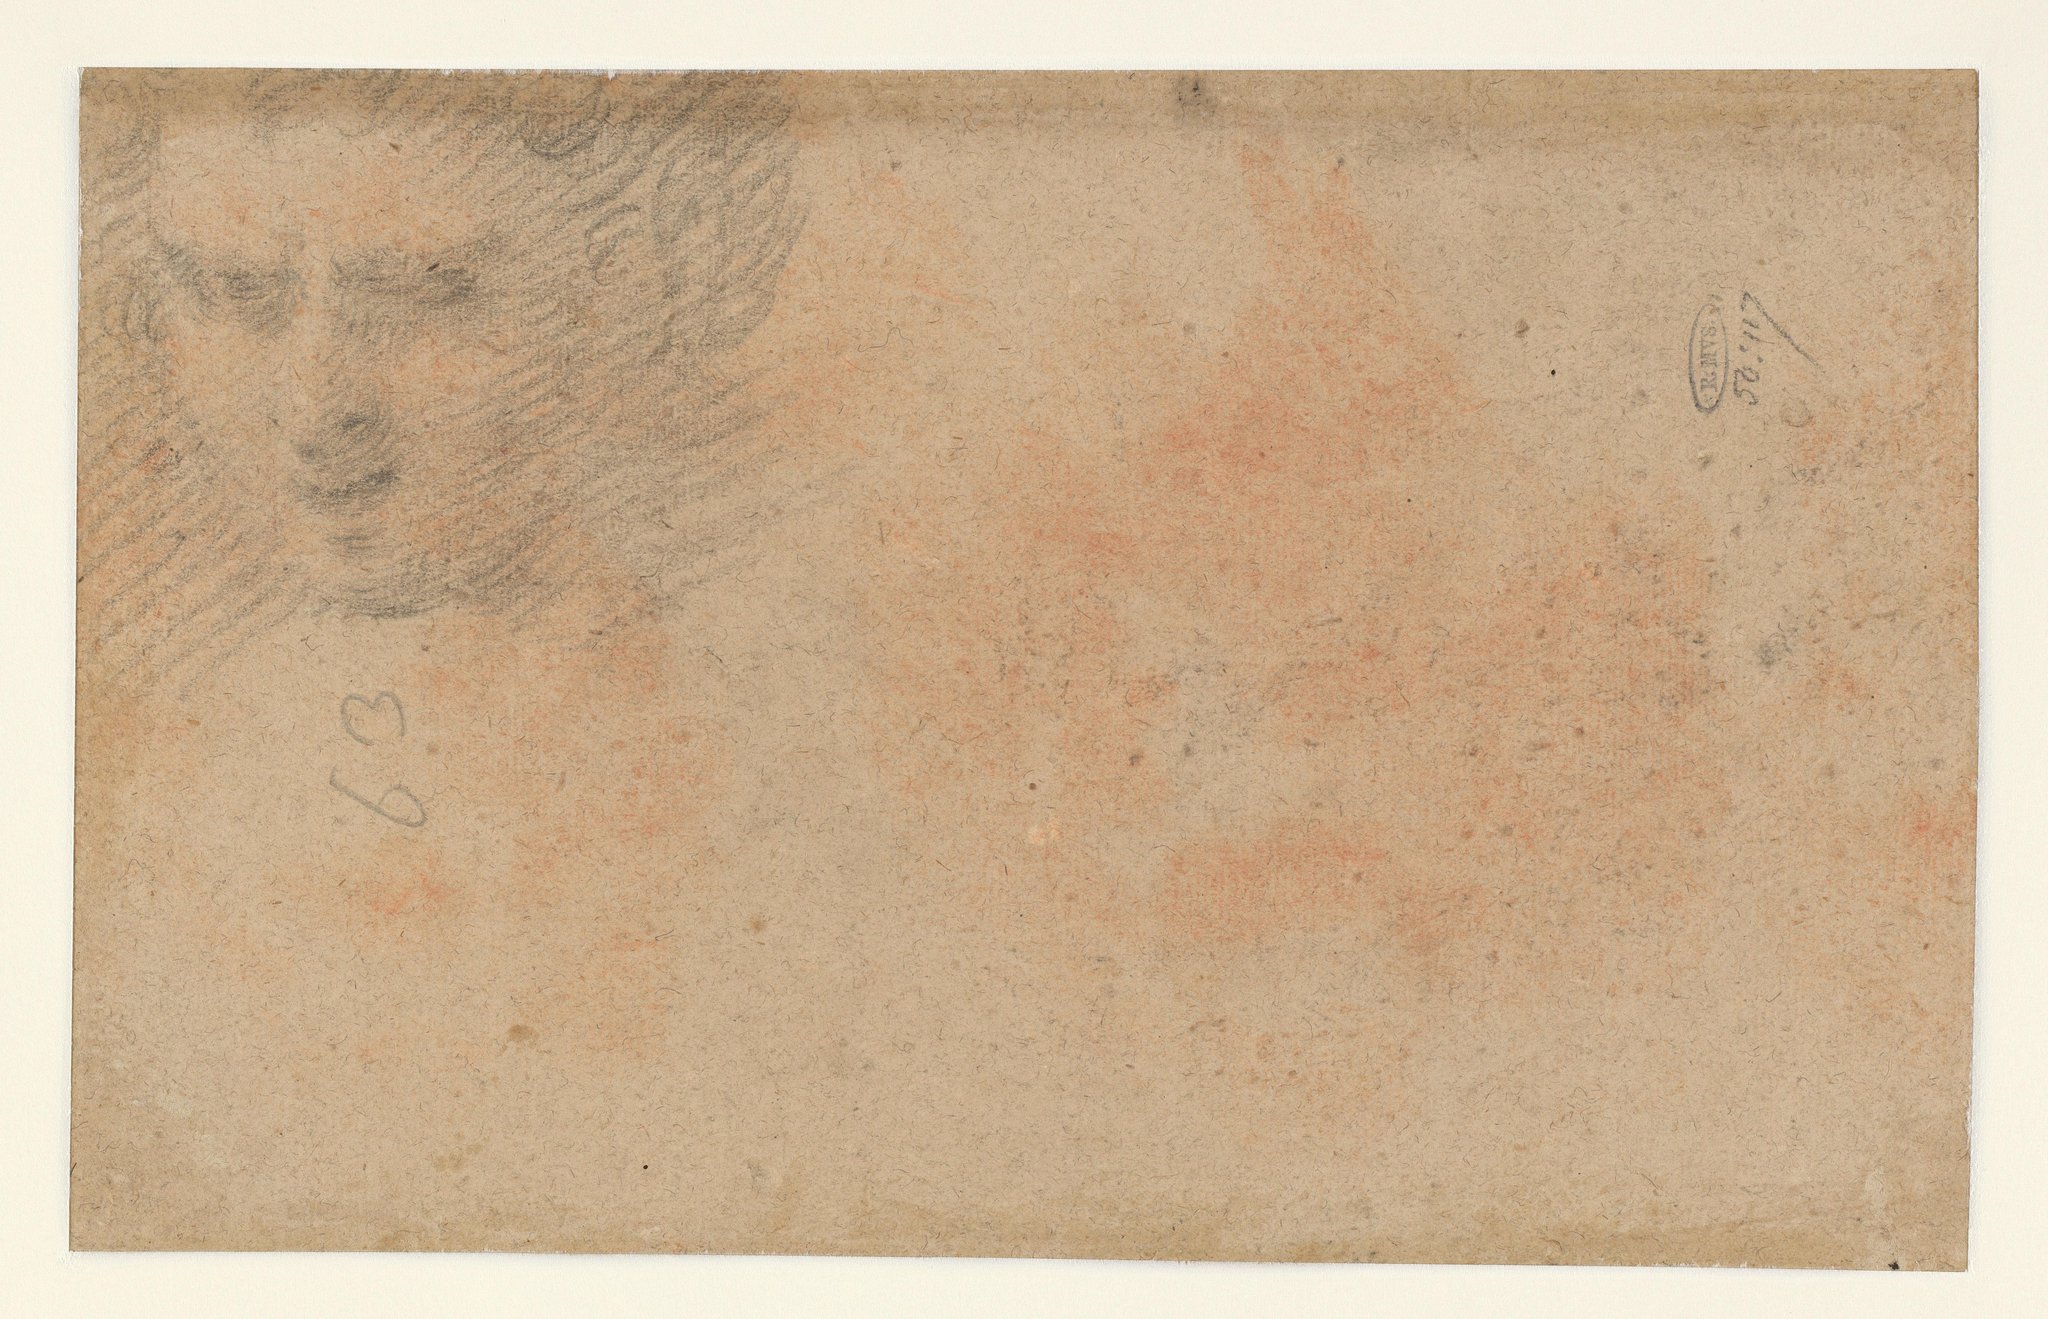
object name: drawing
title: Studie van een gelaatsexpressie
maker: pietro della vecchia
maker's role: draughtsman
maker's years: 1605-1678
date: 1643-1663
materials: chalk, paper